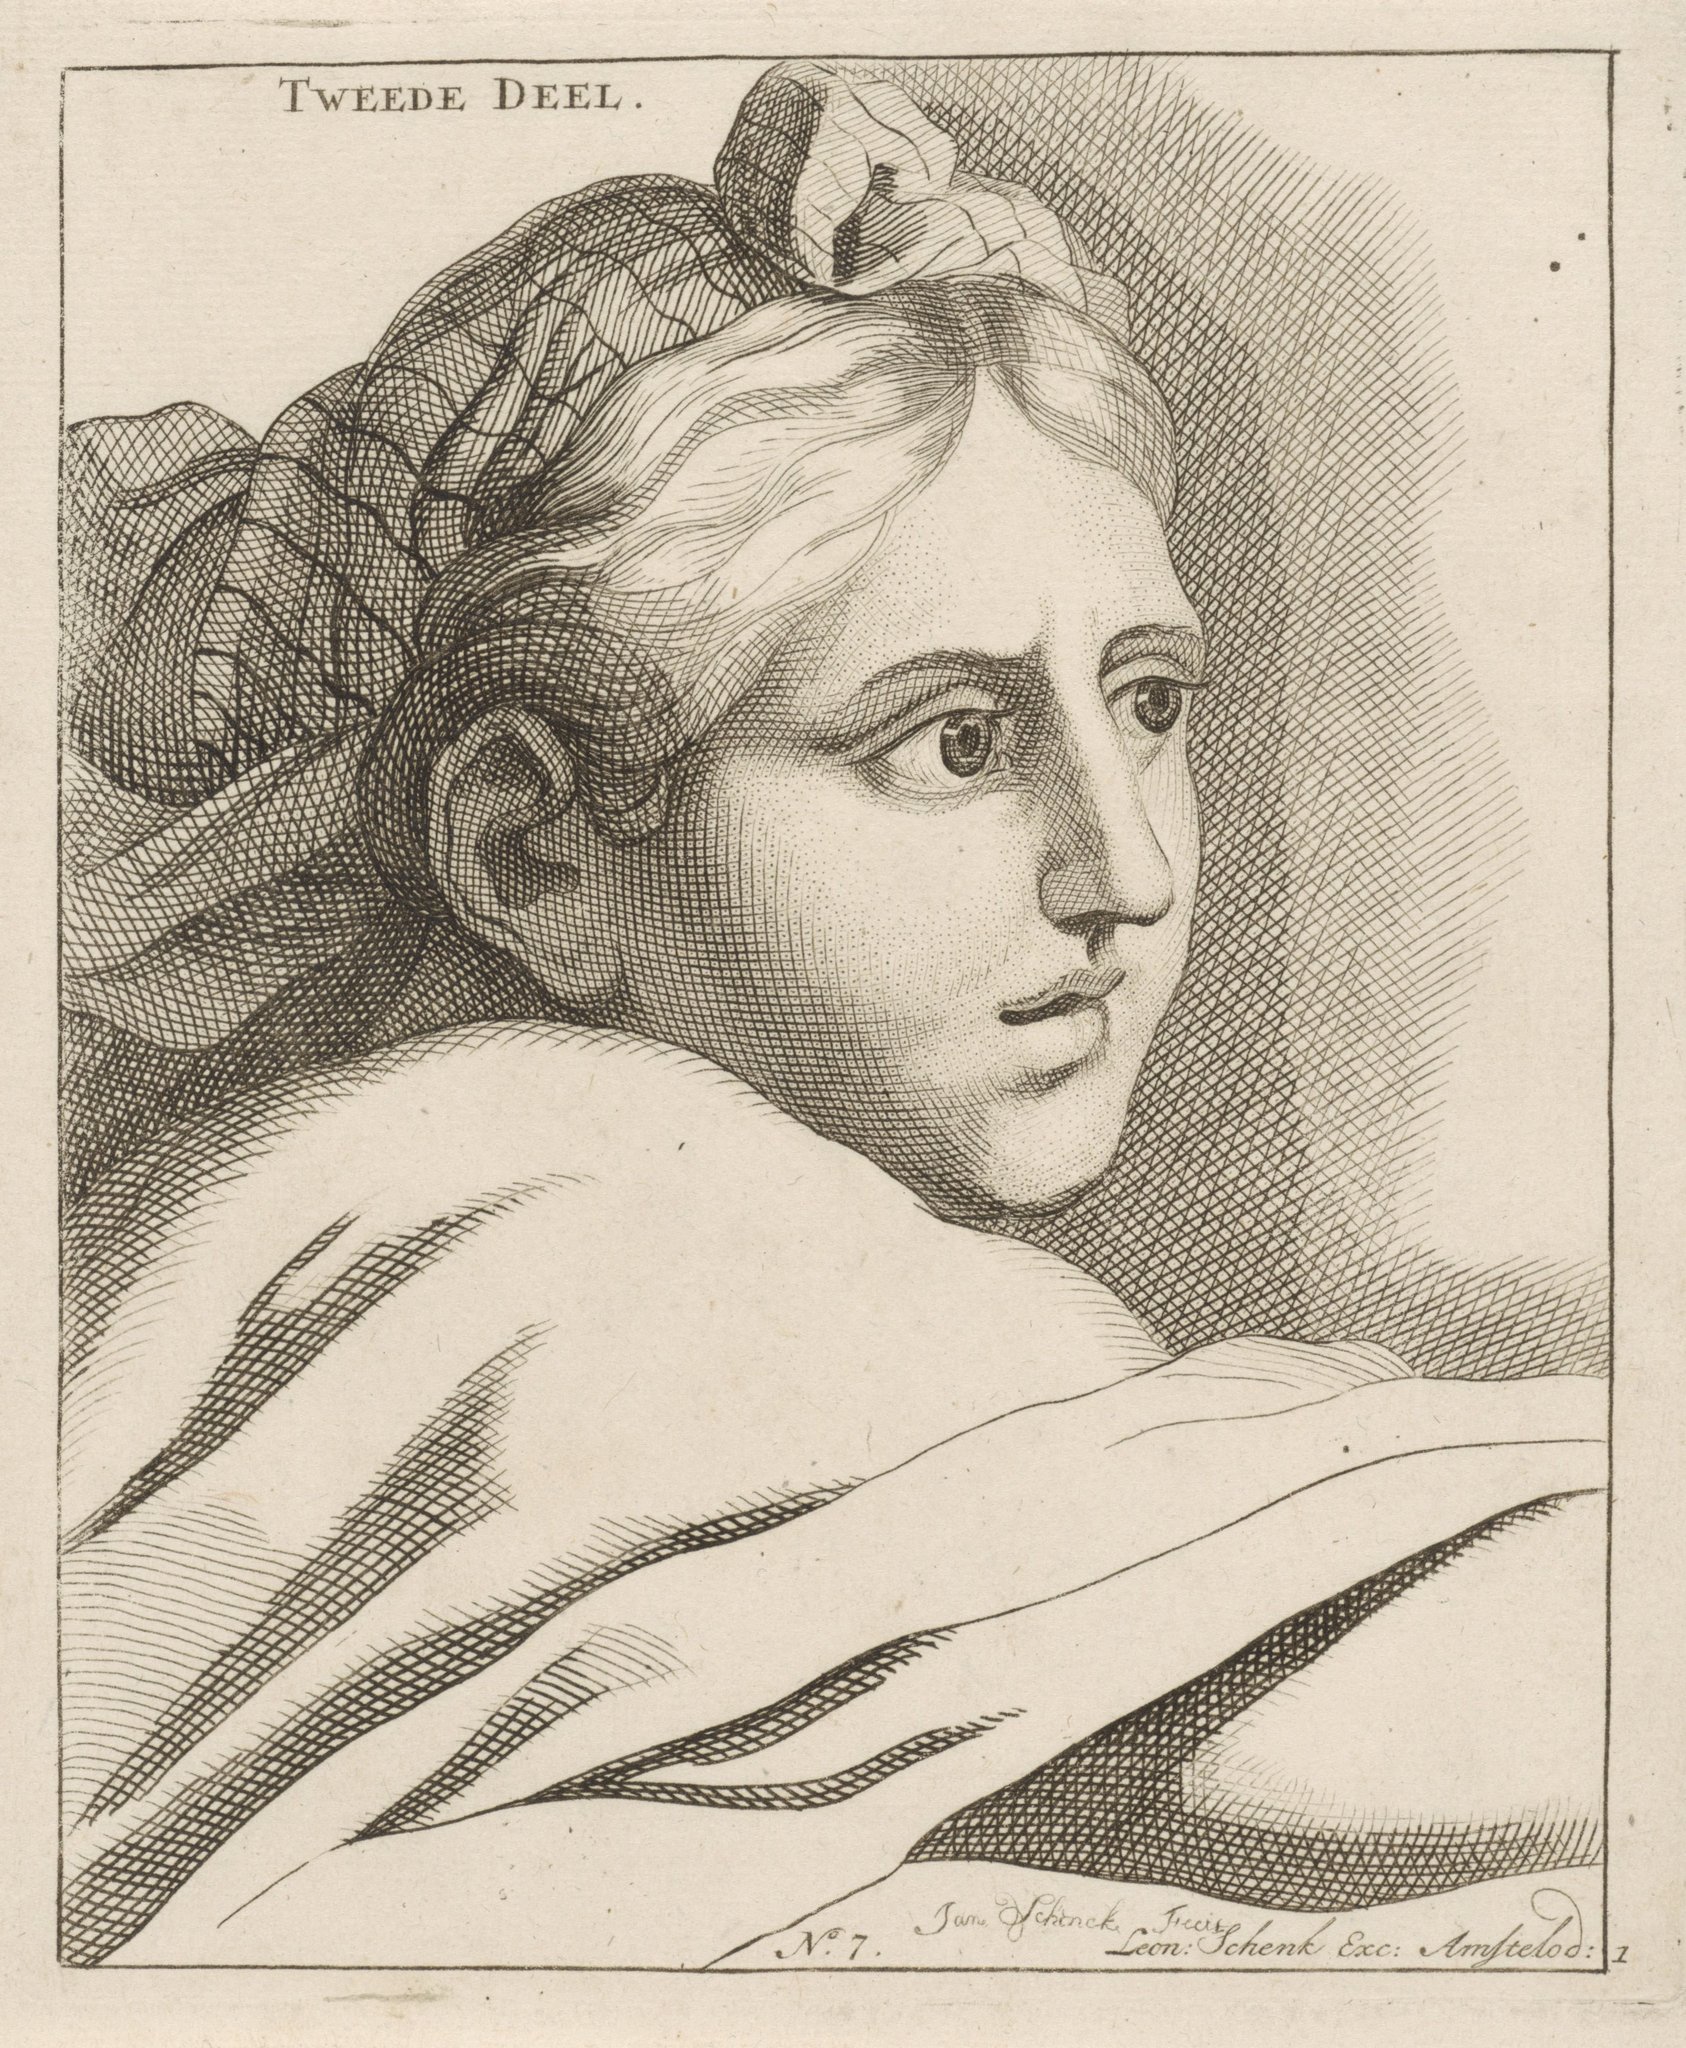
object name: print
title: Tweede Deel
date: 1710-1767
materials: paper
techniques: engraving, etching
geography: amsterdam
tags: head (human) - aa - female human figure (+ three-quarter view), veil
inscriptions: collector's mark: Lugt 2228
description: De prent is vervaardigd naar een figuur op de fresco's van de Sixtijnse Kapel.